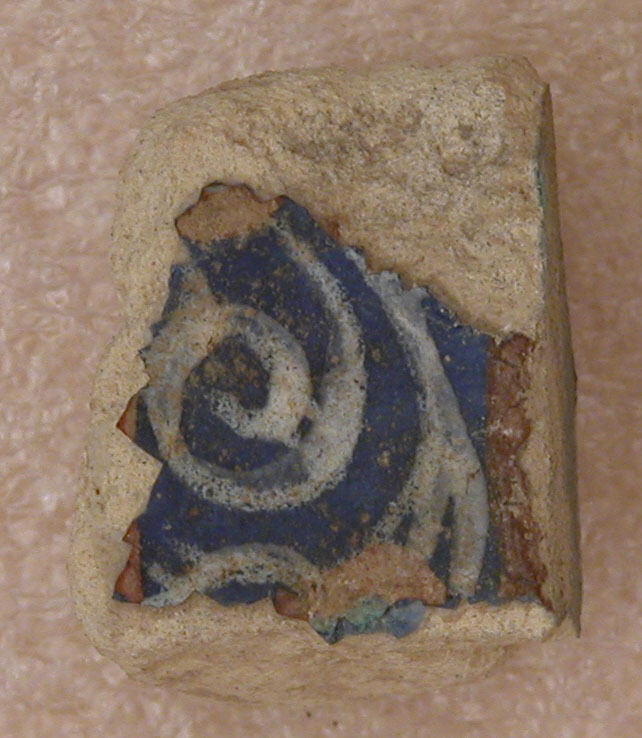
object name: tile fragment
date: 1334-1434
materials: glaze, stonepaste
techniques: painting, polychrome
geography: uzbekistan